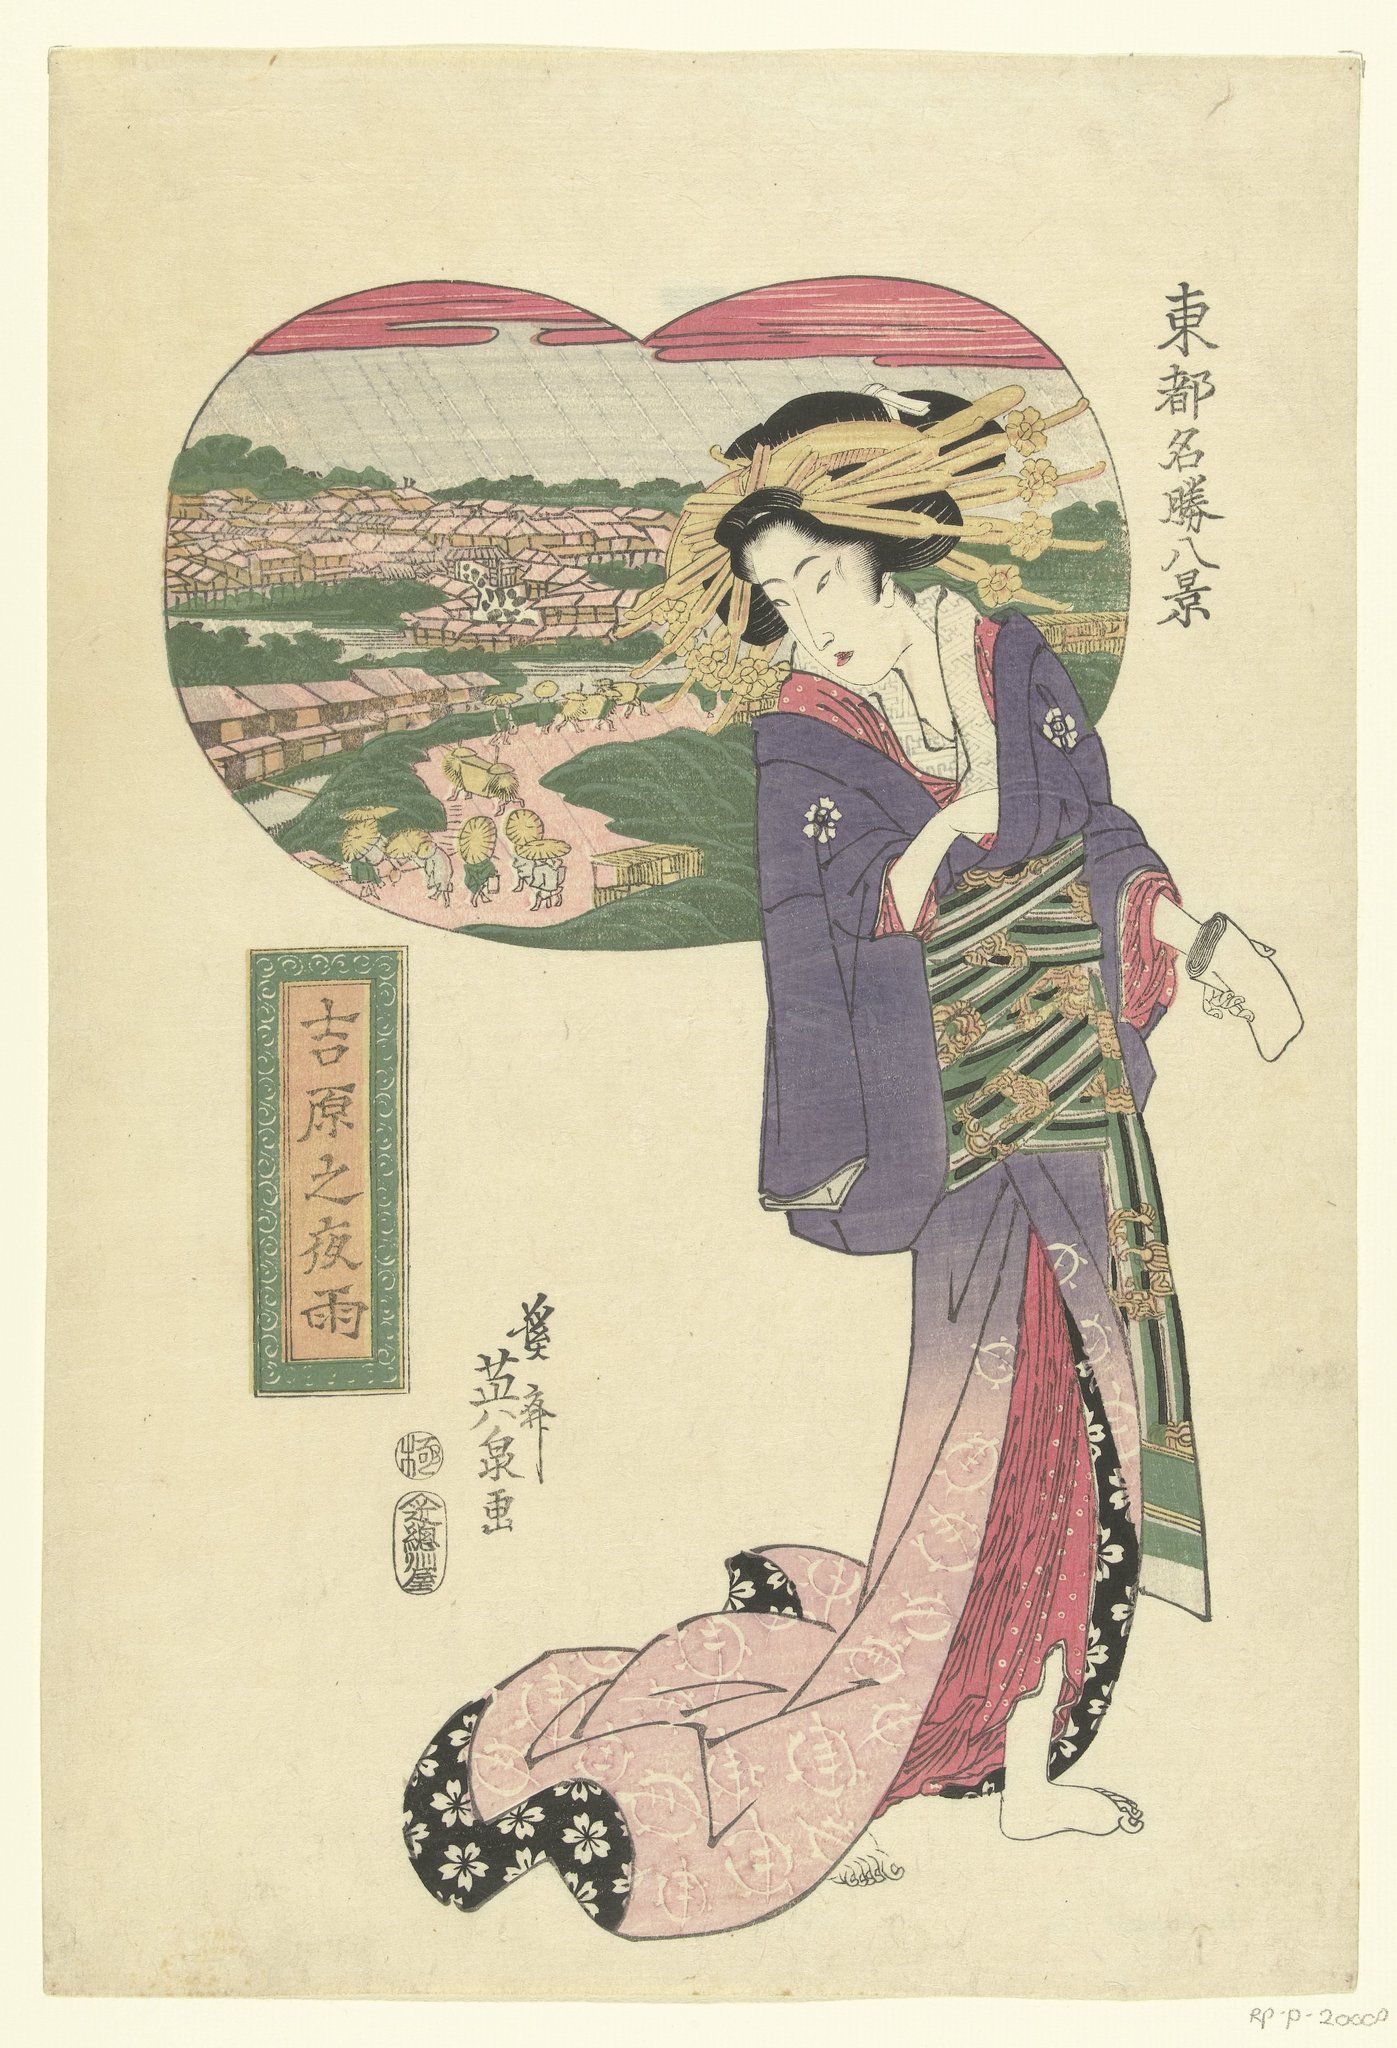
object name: print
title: Nachtelijke regenbui in het Yoshiwara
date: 1800-1848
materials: paper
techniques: woodcut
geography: japan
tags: courtesan, hetaera, rain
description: Courtisane, ten voeten uit, in linker hand een rol tissues, staand tegen hartvormig cartouche waarin regenlandschap met mensen op de weg leidend naar het Yoshiwara, te zien in de achtergrond.